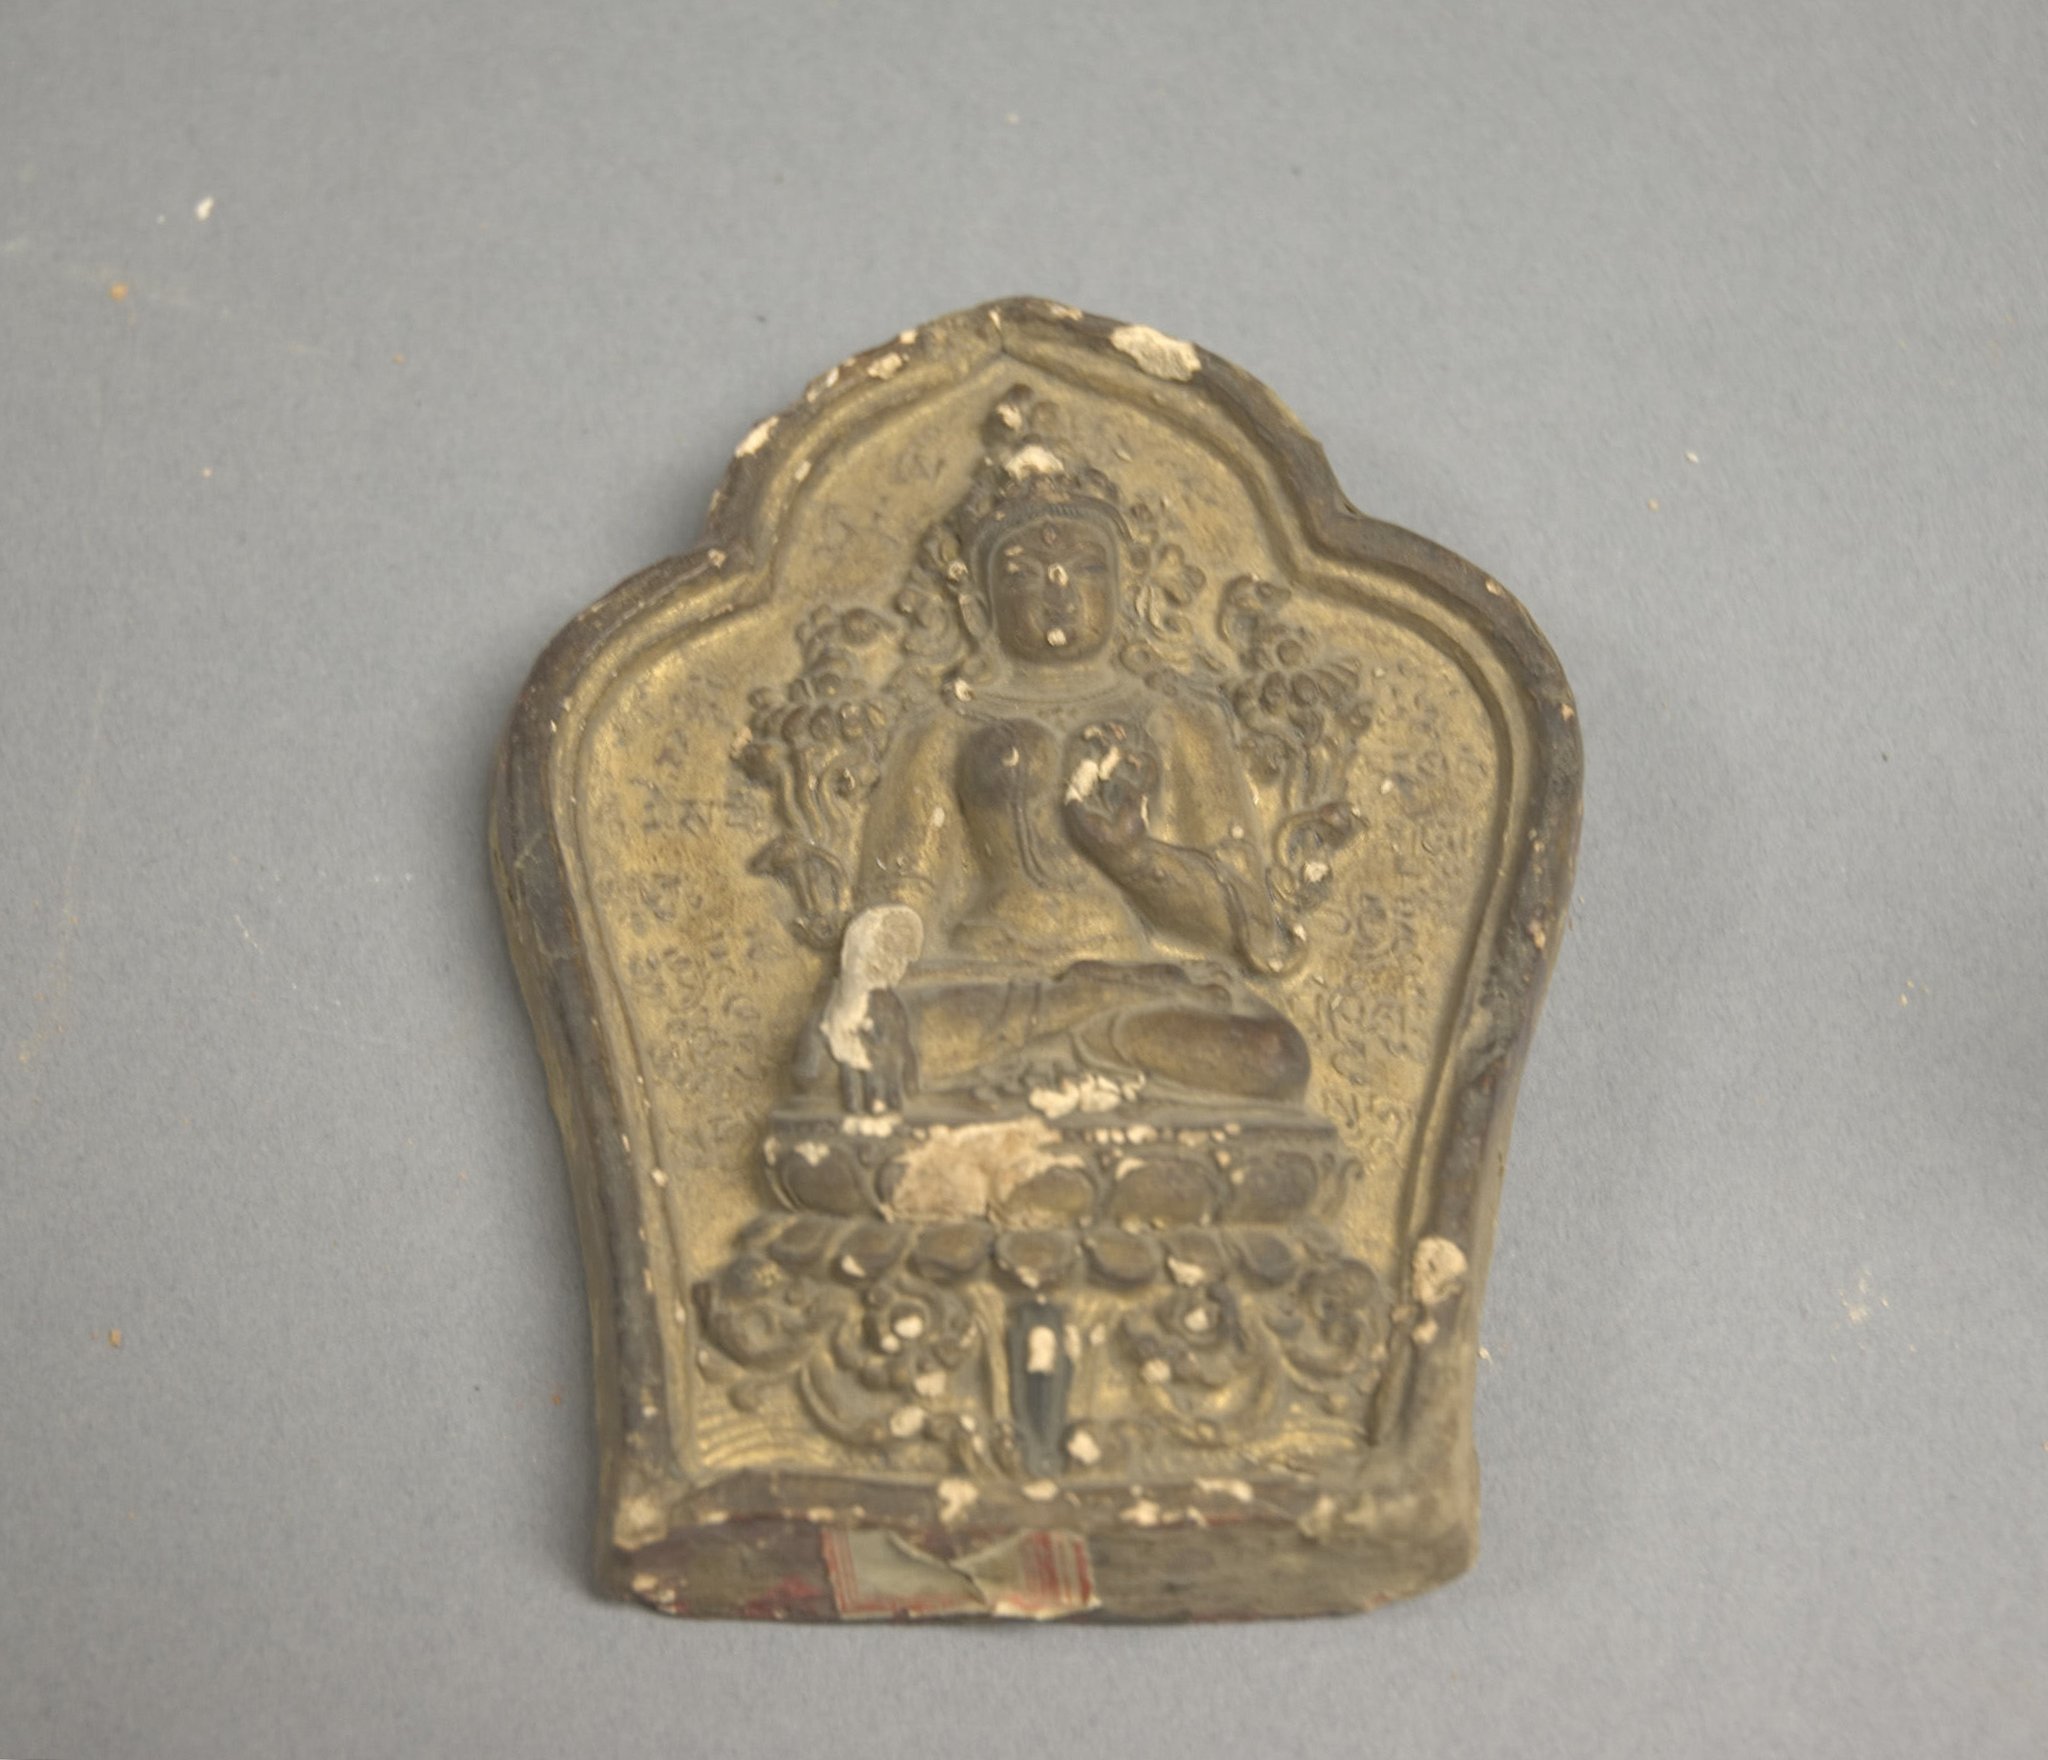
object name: plaque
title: Votive Plaque with White Tara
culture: tibetan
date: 1501-1900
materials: clay, gilt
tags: buddhism,deities